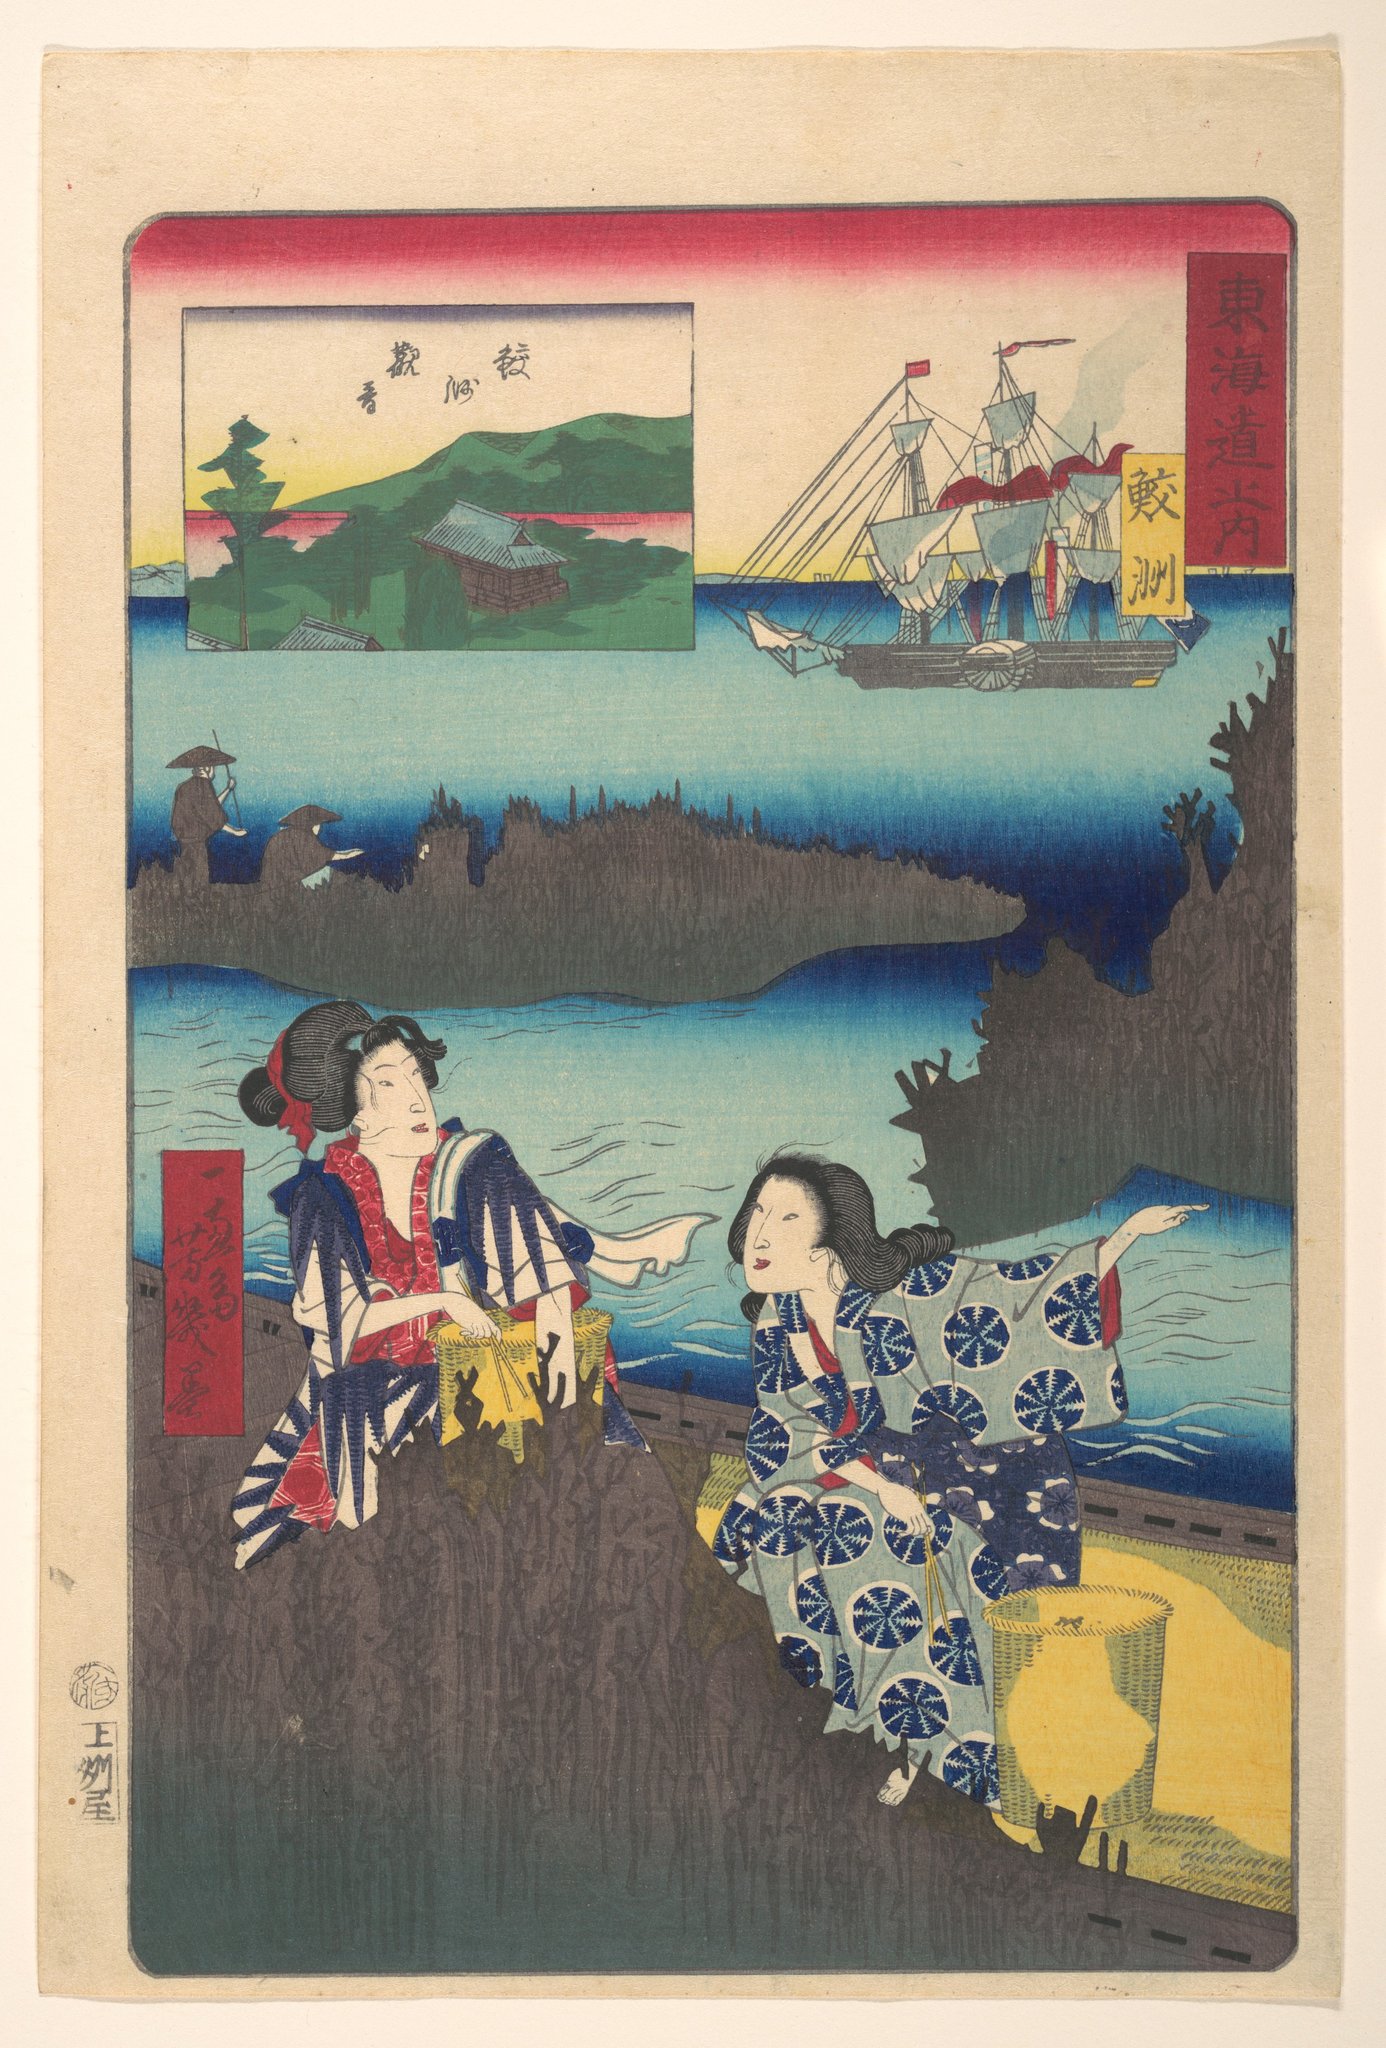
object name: print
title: Gathering Seaweed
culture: japanese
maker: utagawa yoshiiku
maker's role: artist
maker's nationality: japanese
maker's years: 1833-1904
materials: ink, paper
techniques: woodblock print